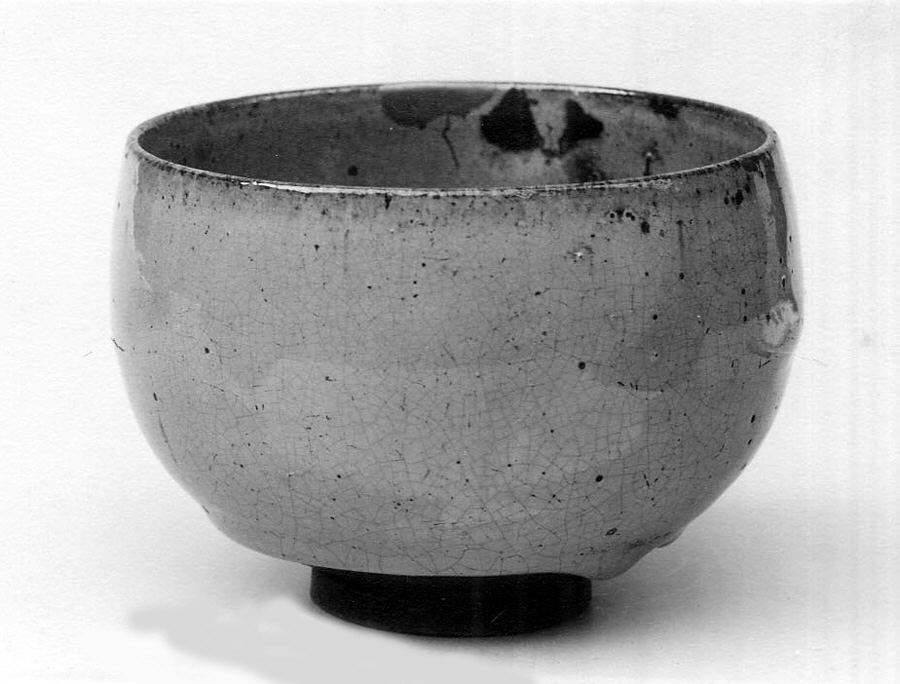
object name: teabowl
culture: japanese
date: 1850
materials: clay